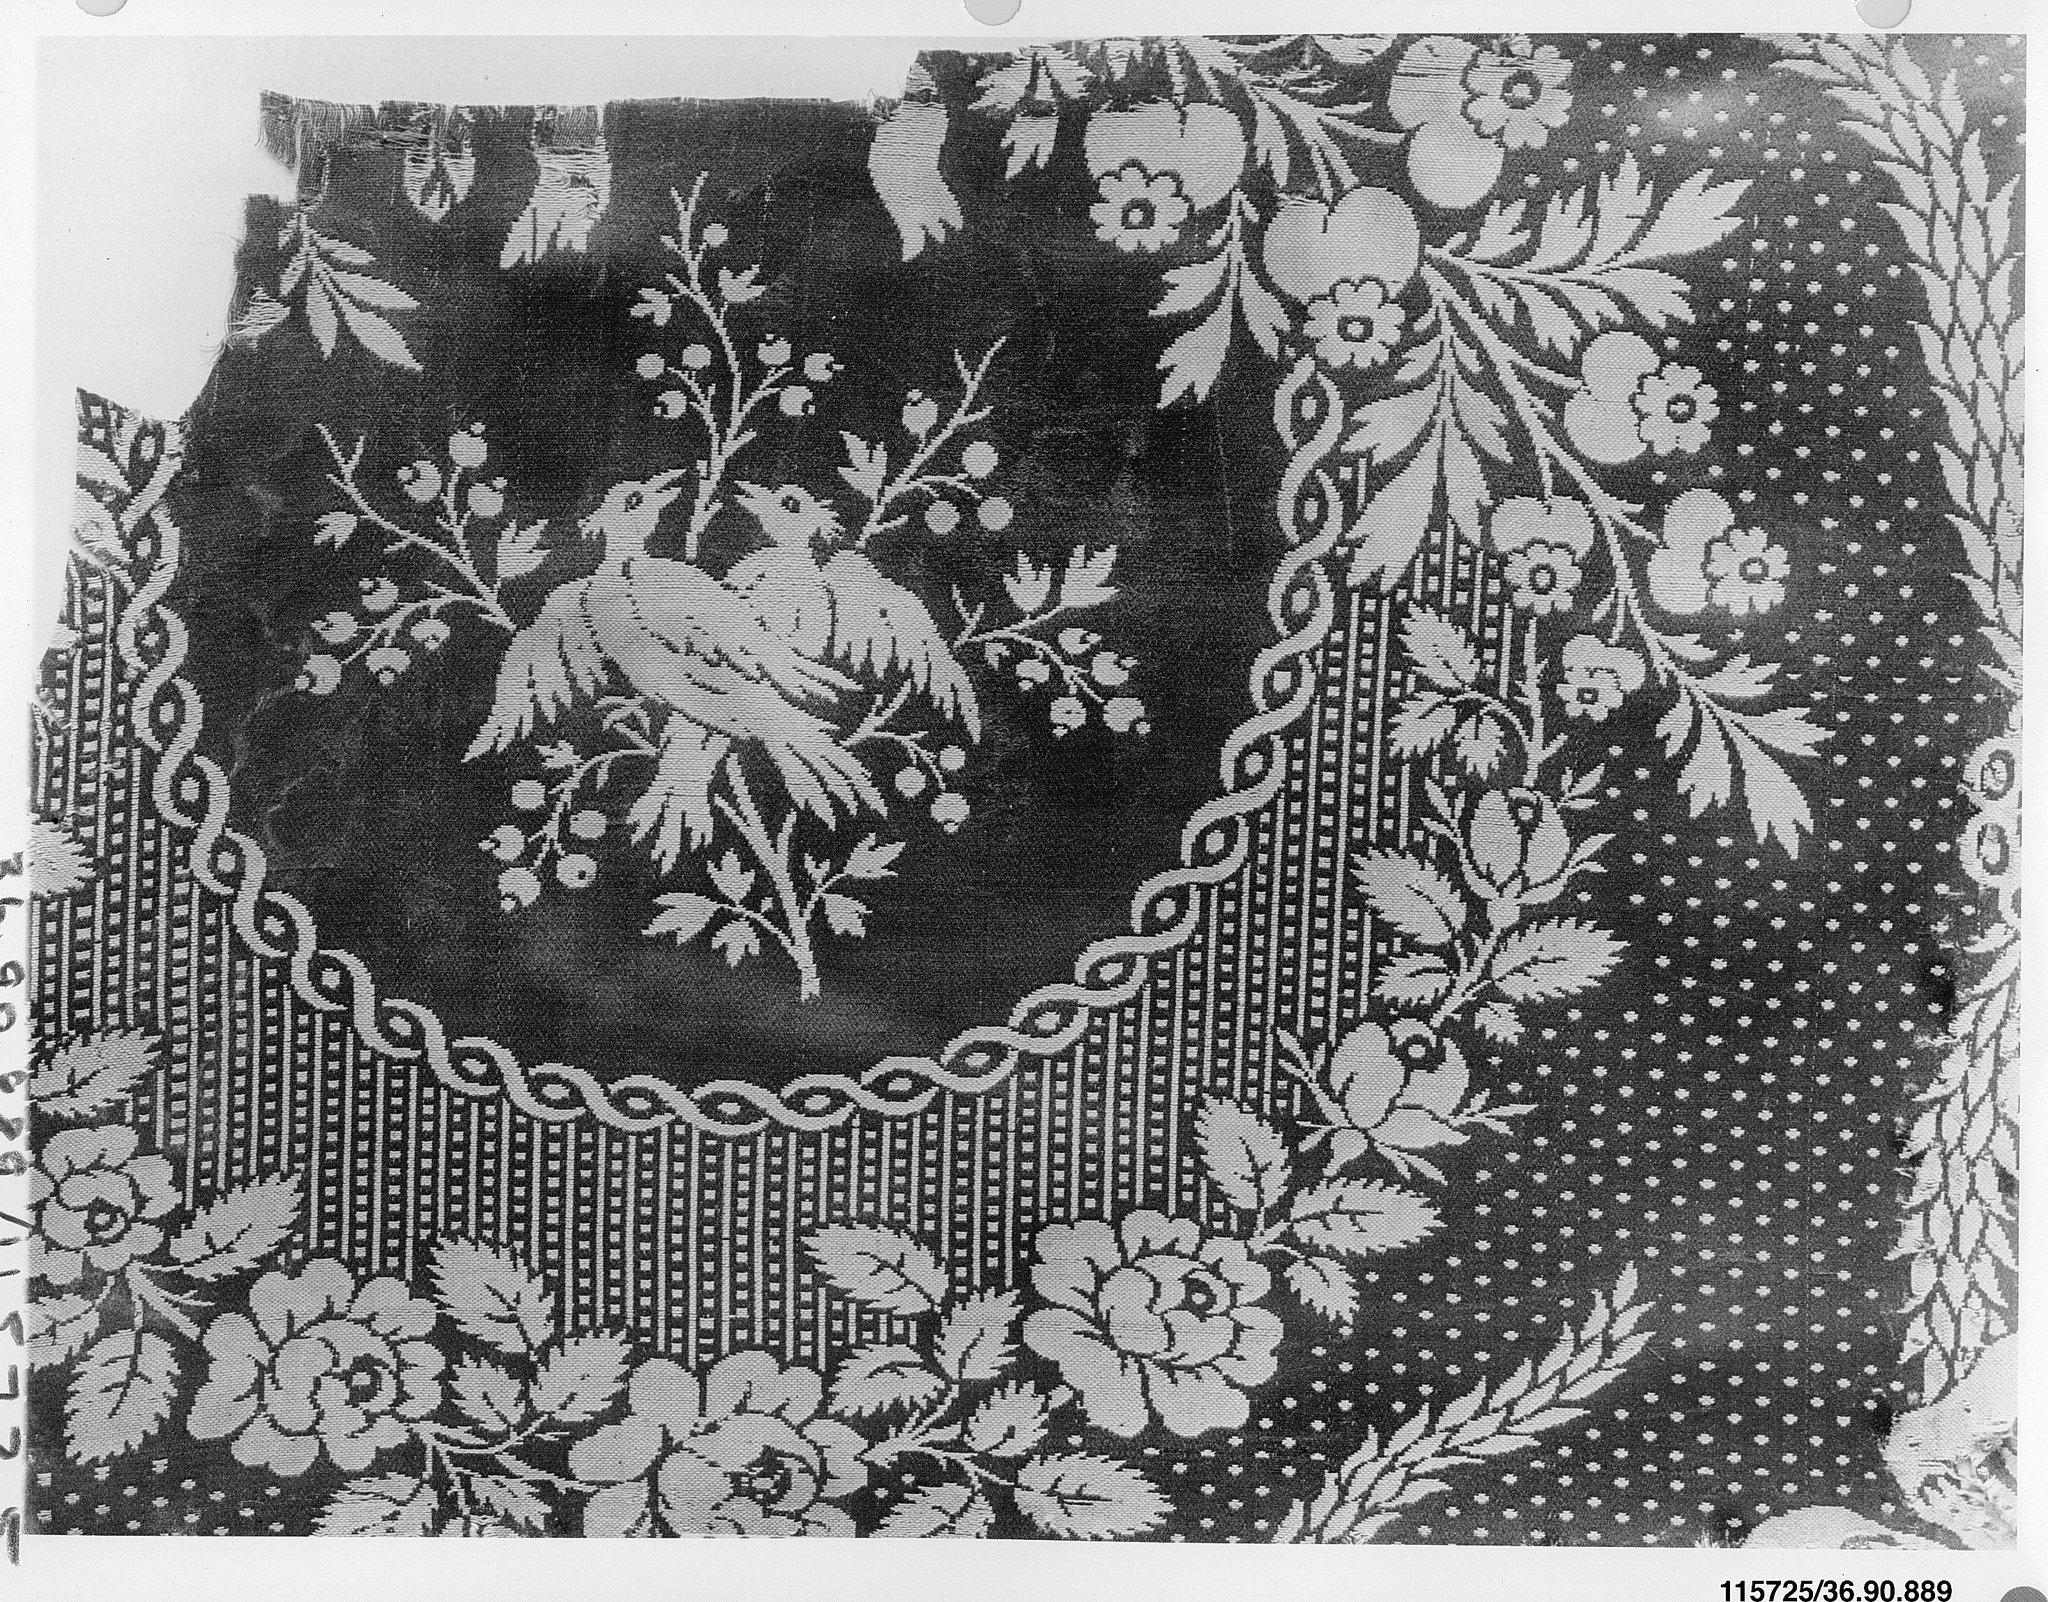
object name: piece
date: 1701-1800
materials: silk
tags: birds,flowers,leaves